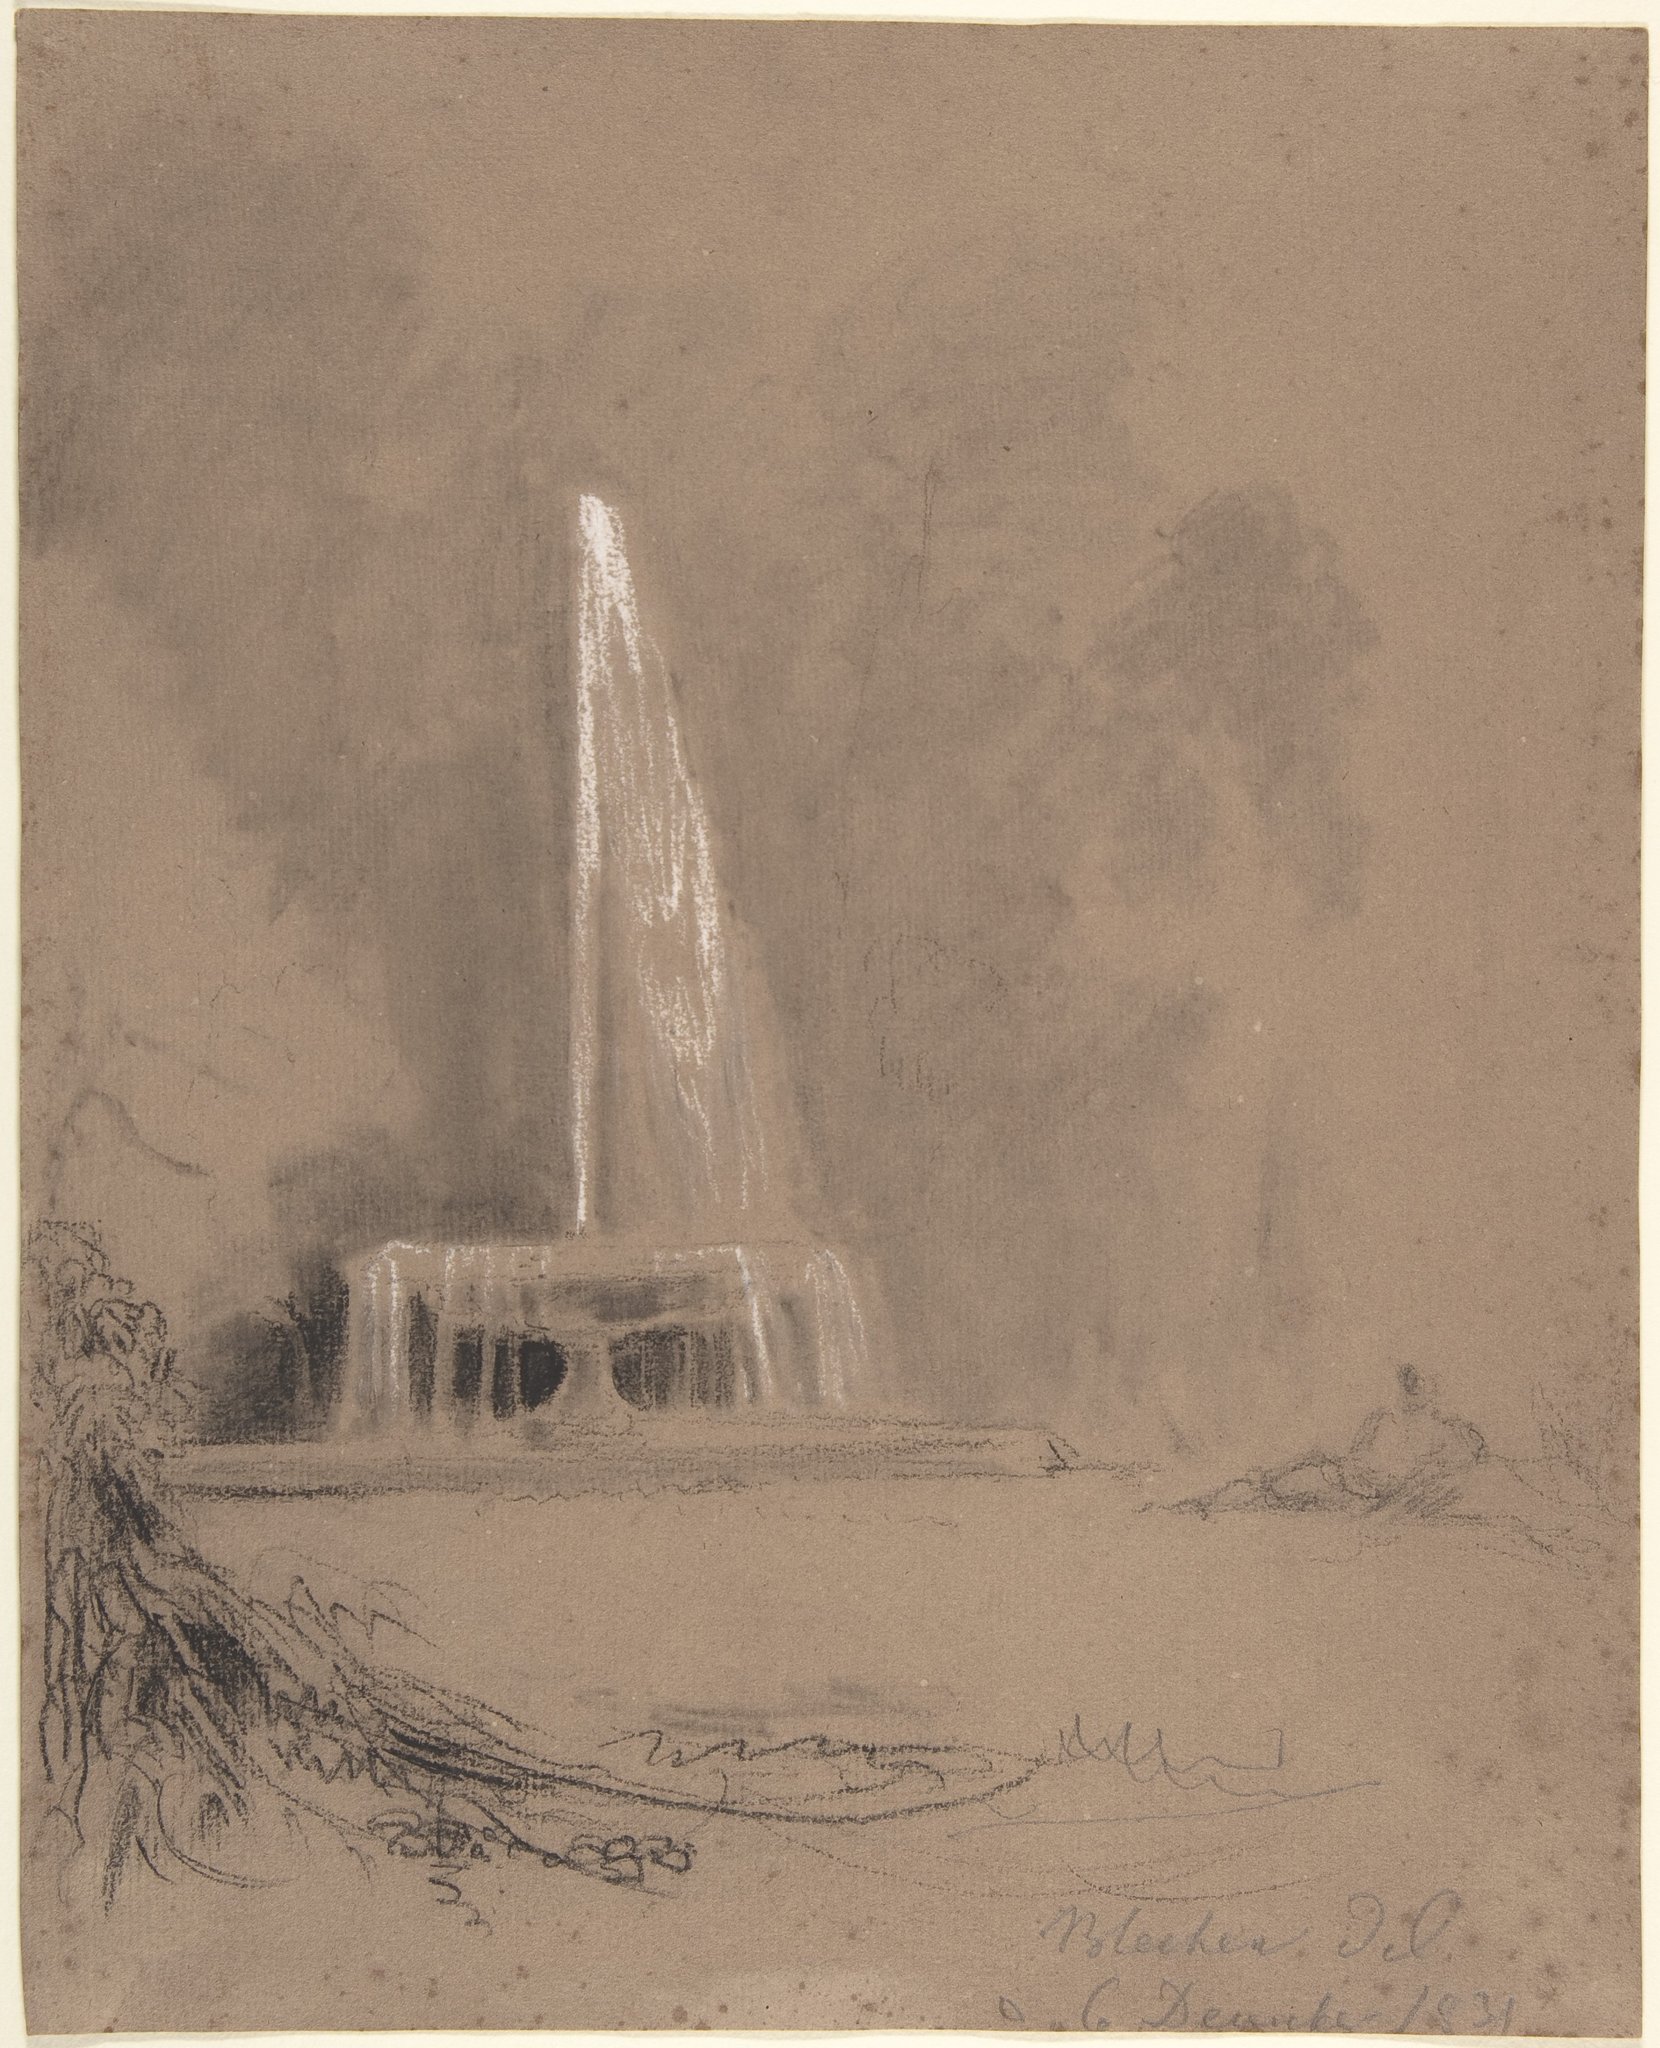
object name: drawing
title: A Fountain in the Park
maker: karl blechen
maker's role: artist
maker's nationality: german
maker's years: 1798-1840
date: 1831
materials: chalk, graphite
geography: germany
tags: fountains